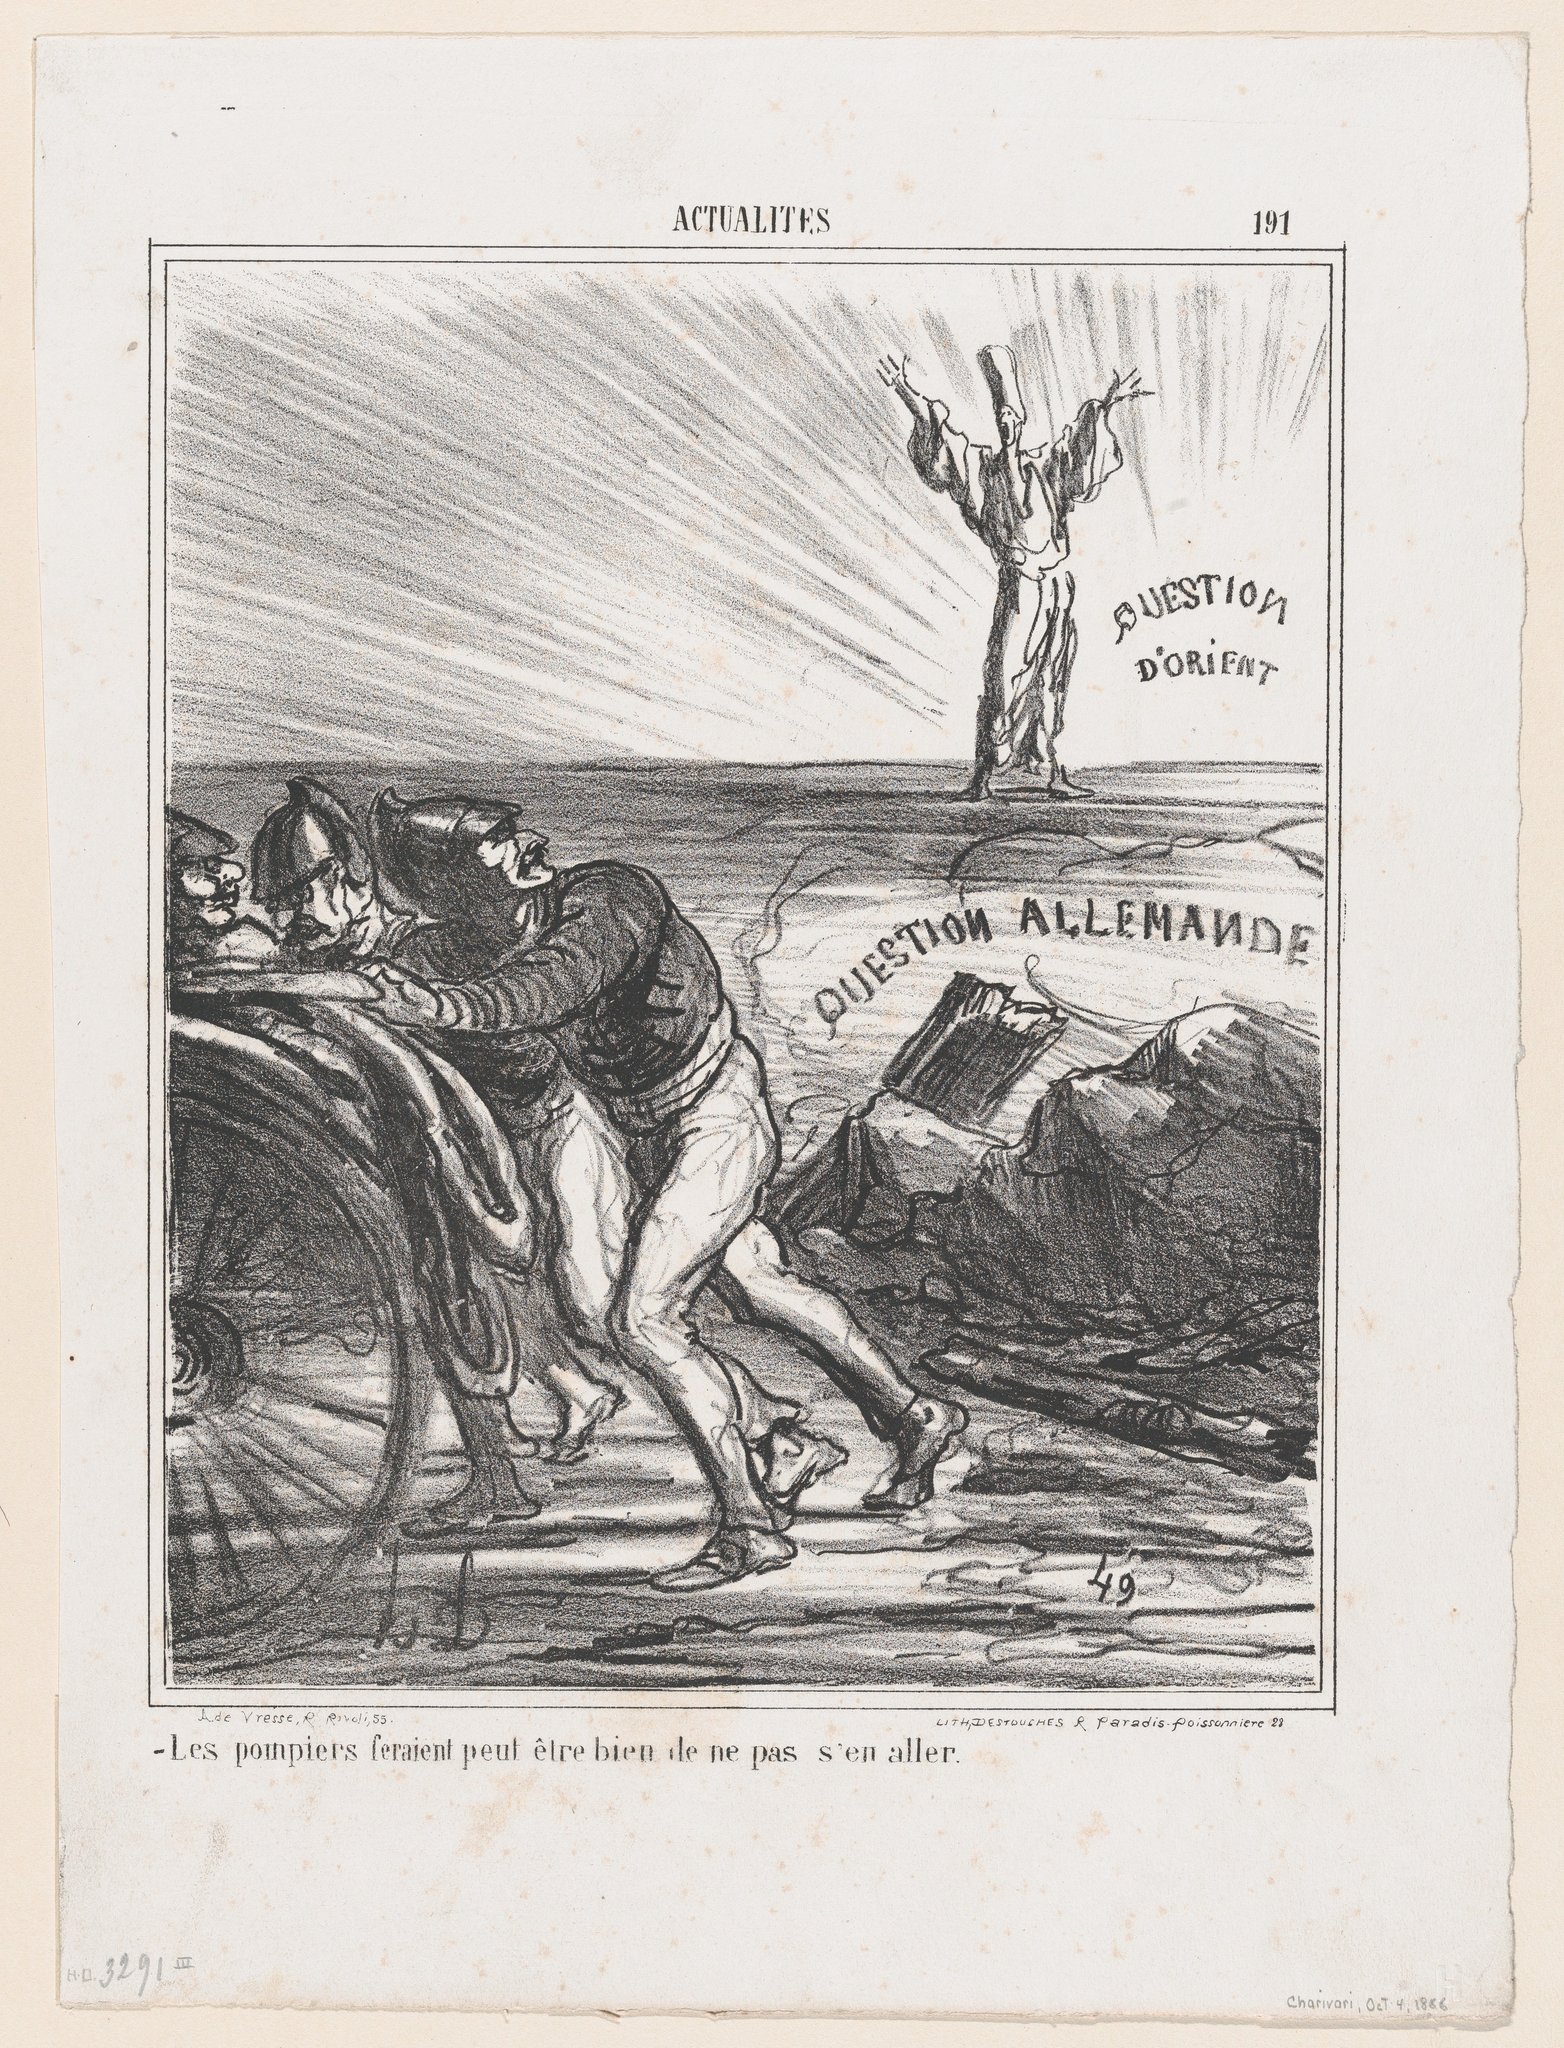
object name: print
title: Maybe the firemen really shouldn't leave just yet, from 'News of the day,' published in "Le Charivari"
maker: honoré daumier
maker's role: artist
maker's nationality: french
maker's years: 1808-1879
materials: paper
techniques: lithograph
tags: men,working